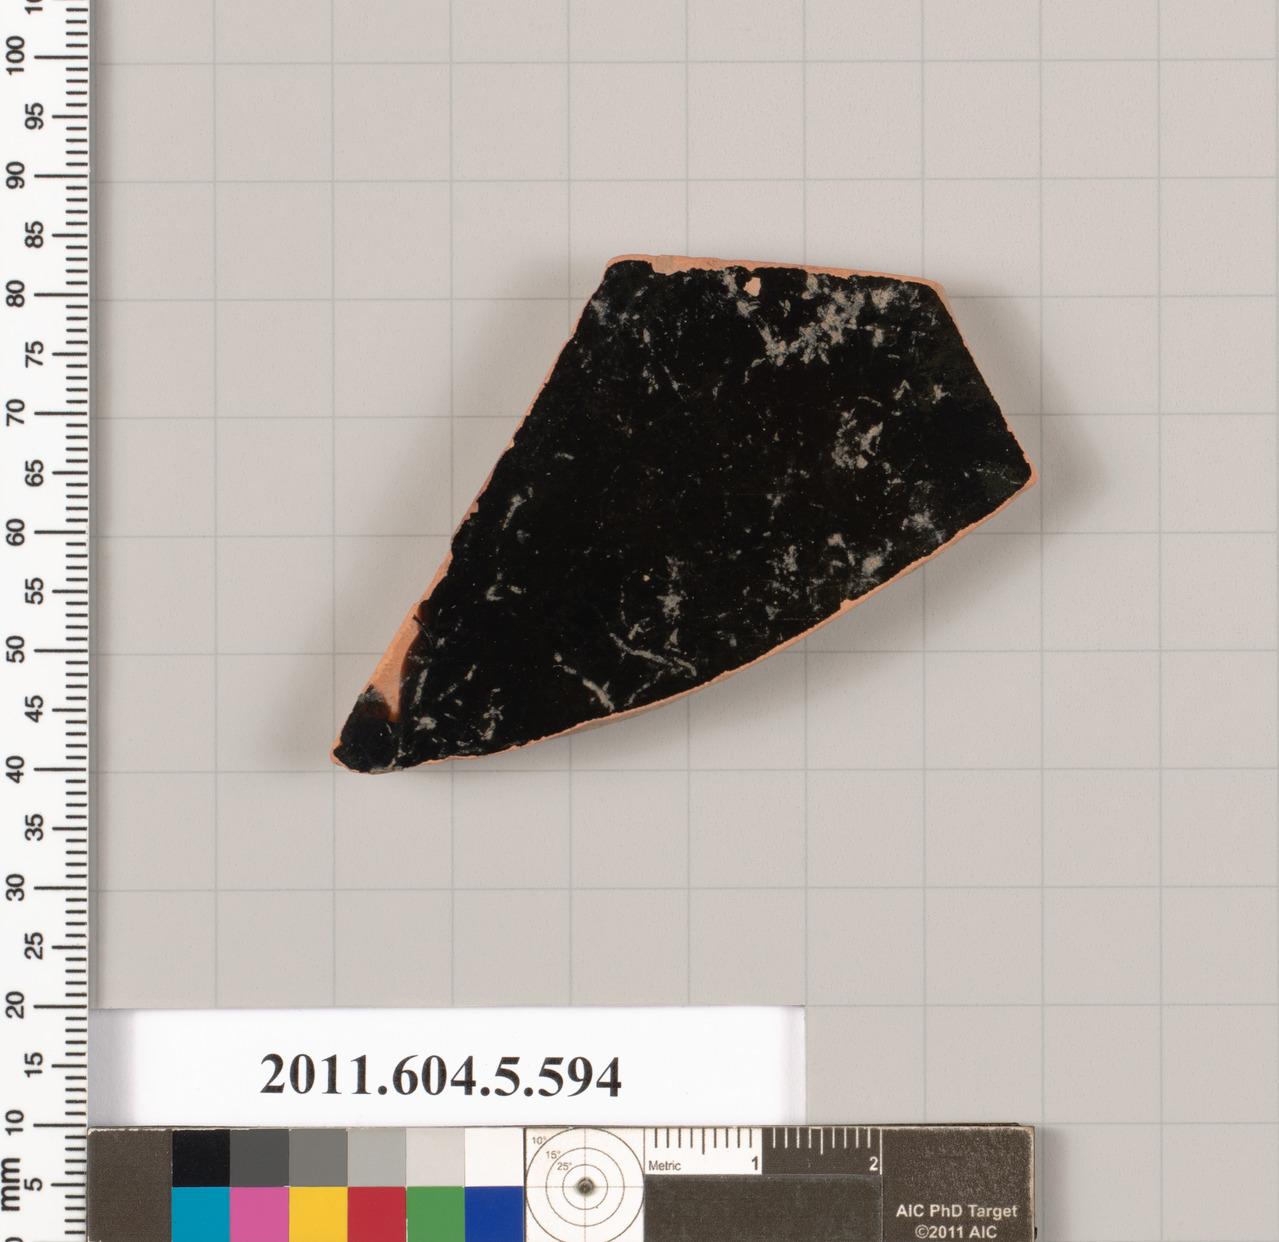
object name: kylix fragment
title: Terracotta fragment of a kylix (drinking cup)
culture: greek, attic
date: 600-401 BCE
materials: terracotta